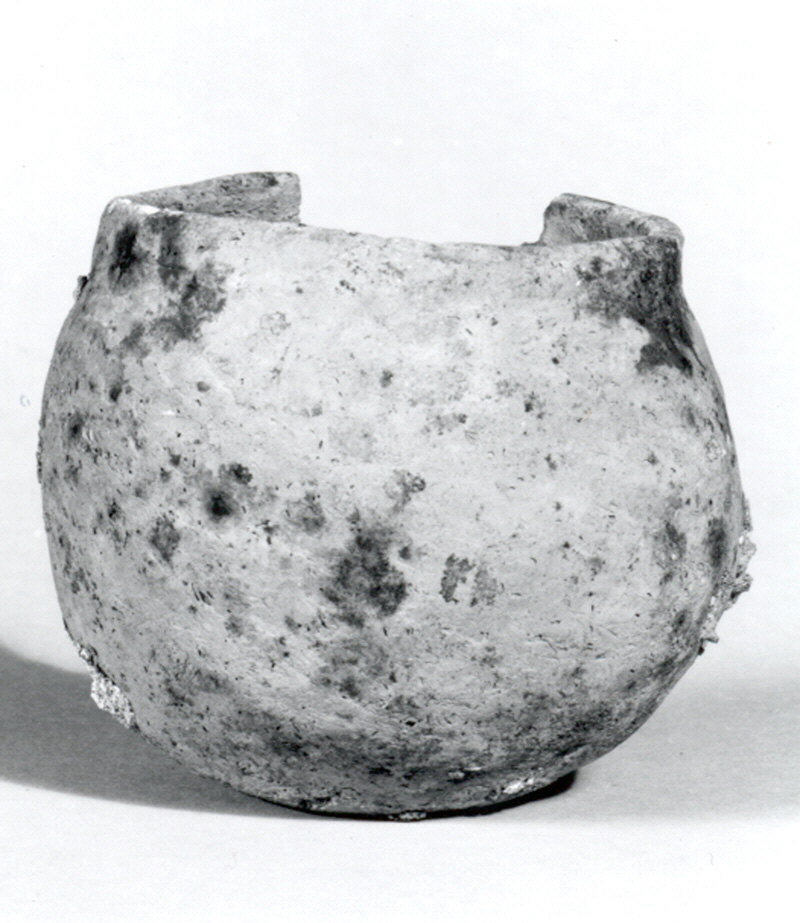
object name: pot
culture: iranian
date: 6000-5001 BCE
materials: ceramic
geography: iran